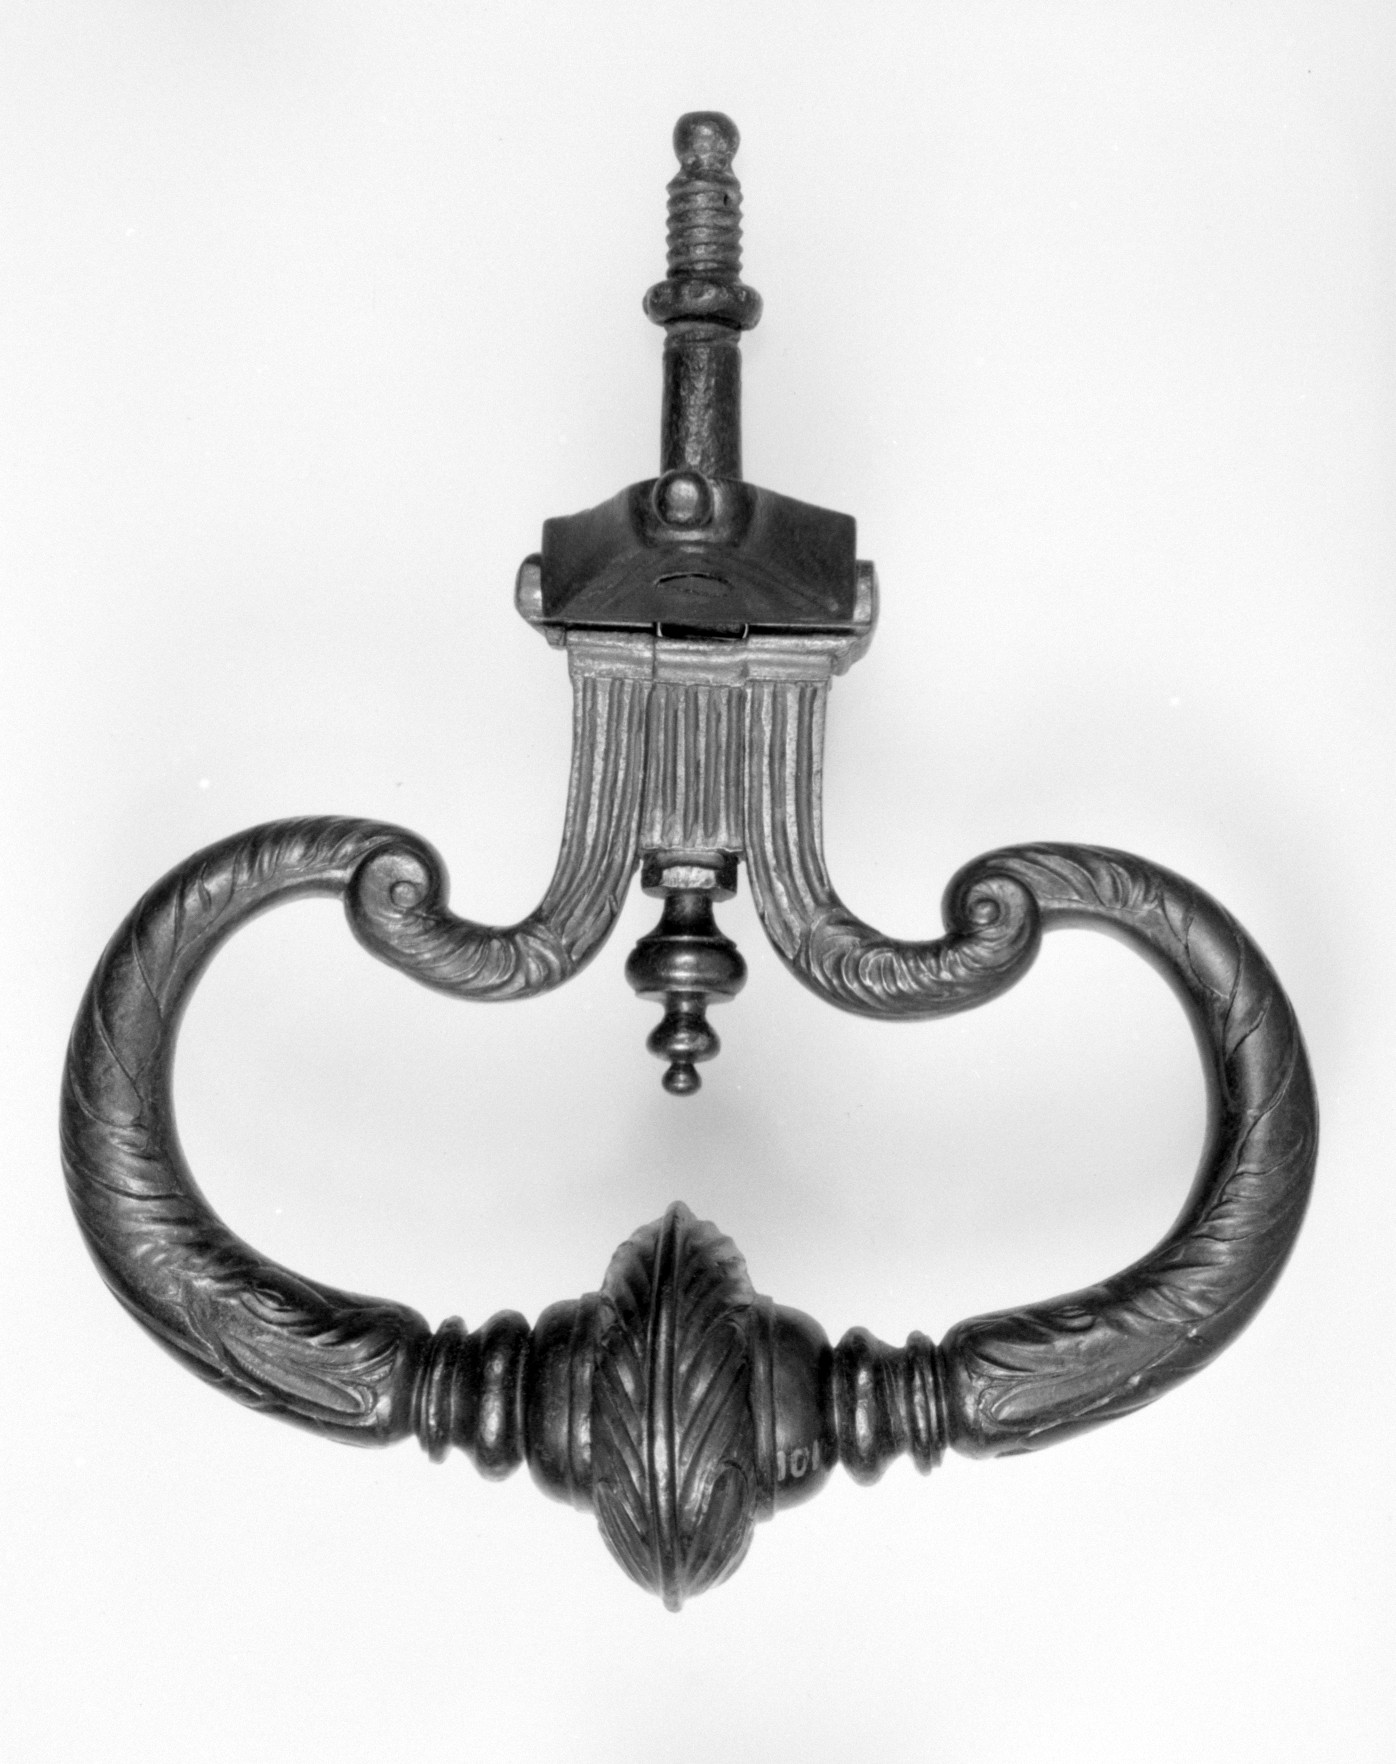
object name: door knocker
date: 1676-1700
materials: iron